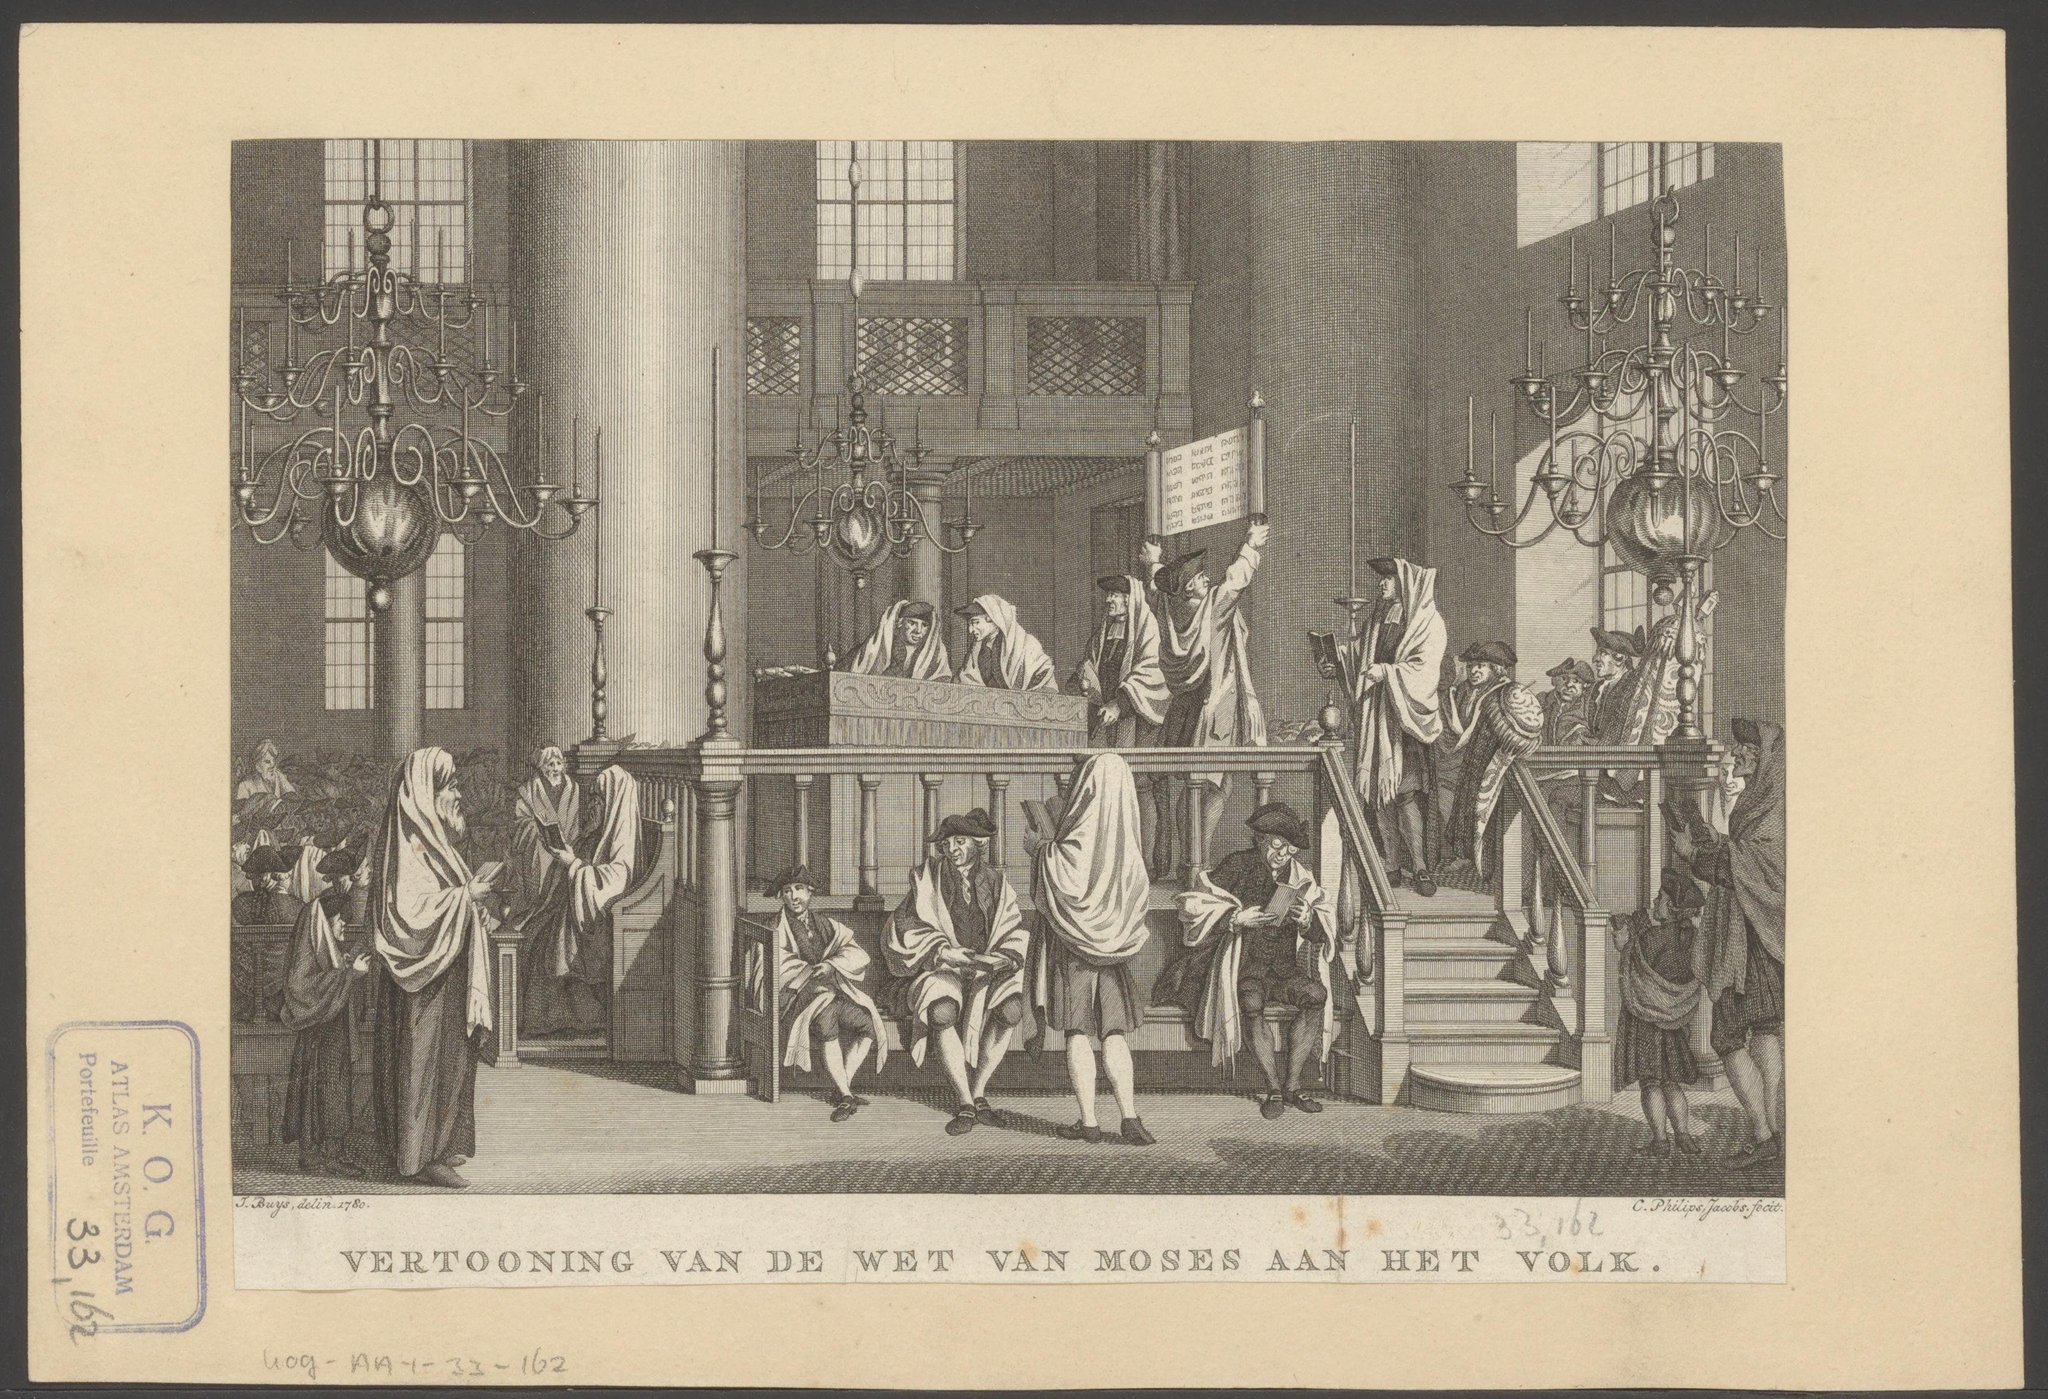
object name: print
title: Vertooning van de wet van Moses aan het volk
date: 1781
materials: paper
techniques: engraving, etching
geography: amsterdam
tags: 'simhat torah', rejoicing in the law ~ 'sukkot', the synagogue (as building and place of worship ~ jewish religion), 'sefer torah', scroll of the law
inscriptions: collector's mark: Lugt 1641b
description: Prent mogelijk uit: Hurd, William. Oude en tegenwoordige staat en geschiedenis van alle godsdiensten (...). Amsterdam: Martinus de Bruyn, 1781, dl. 1.